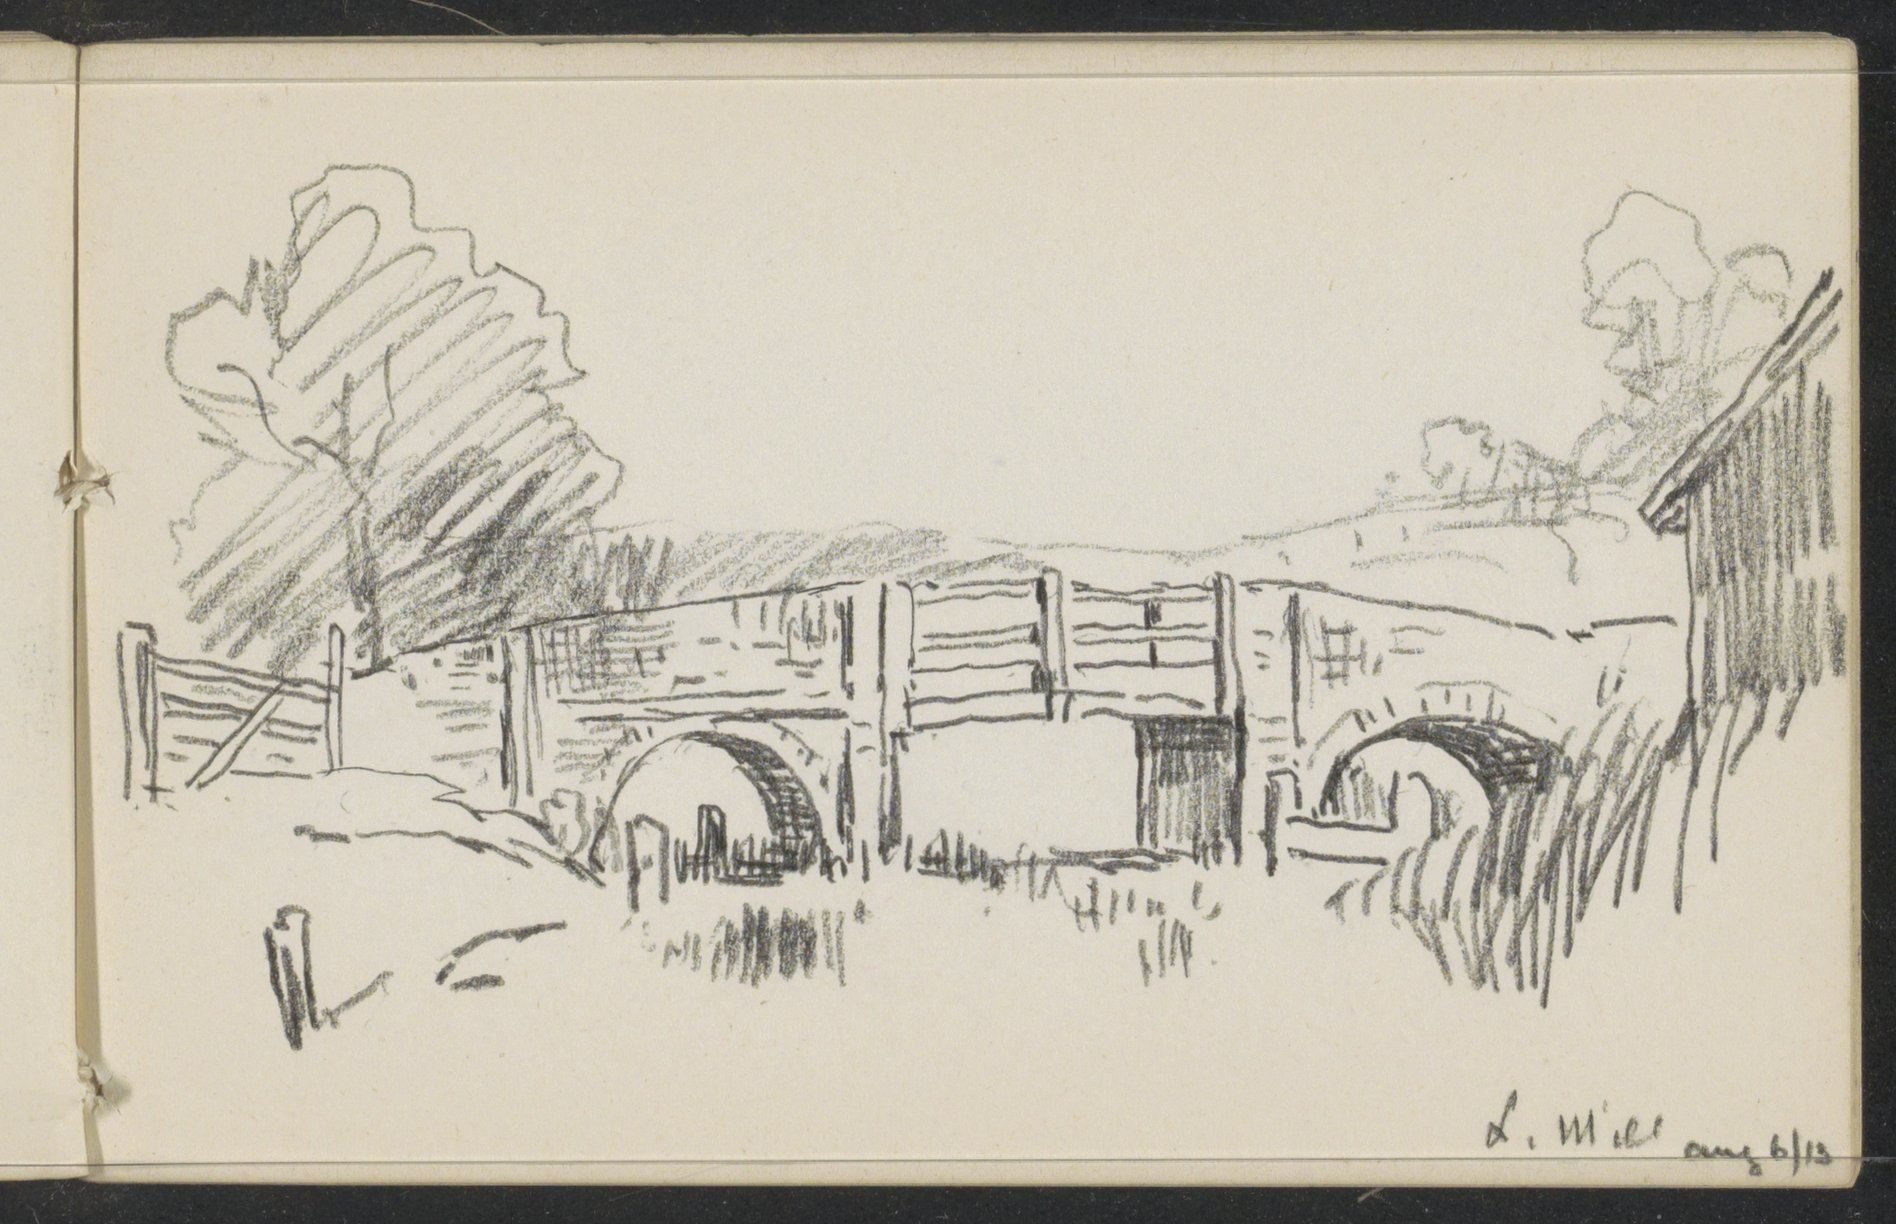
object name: sketchbook leaf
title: Brug bij Langham Mill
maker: alexander shilling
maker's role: draughtsman, print maker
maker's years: 1859-1937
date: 1908-1913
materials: chalk, paper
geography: langham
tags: landscapes with waters, waterscapes, seascapes (in the temperate zone), bridge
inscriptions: date and inscription: ‘L. Mill aug 6/13’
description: Blad 17 recto uit een schetsboek met 30 bladen.